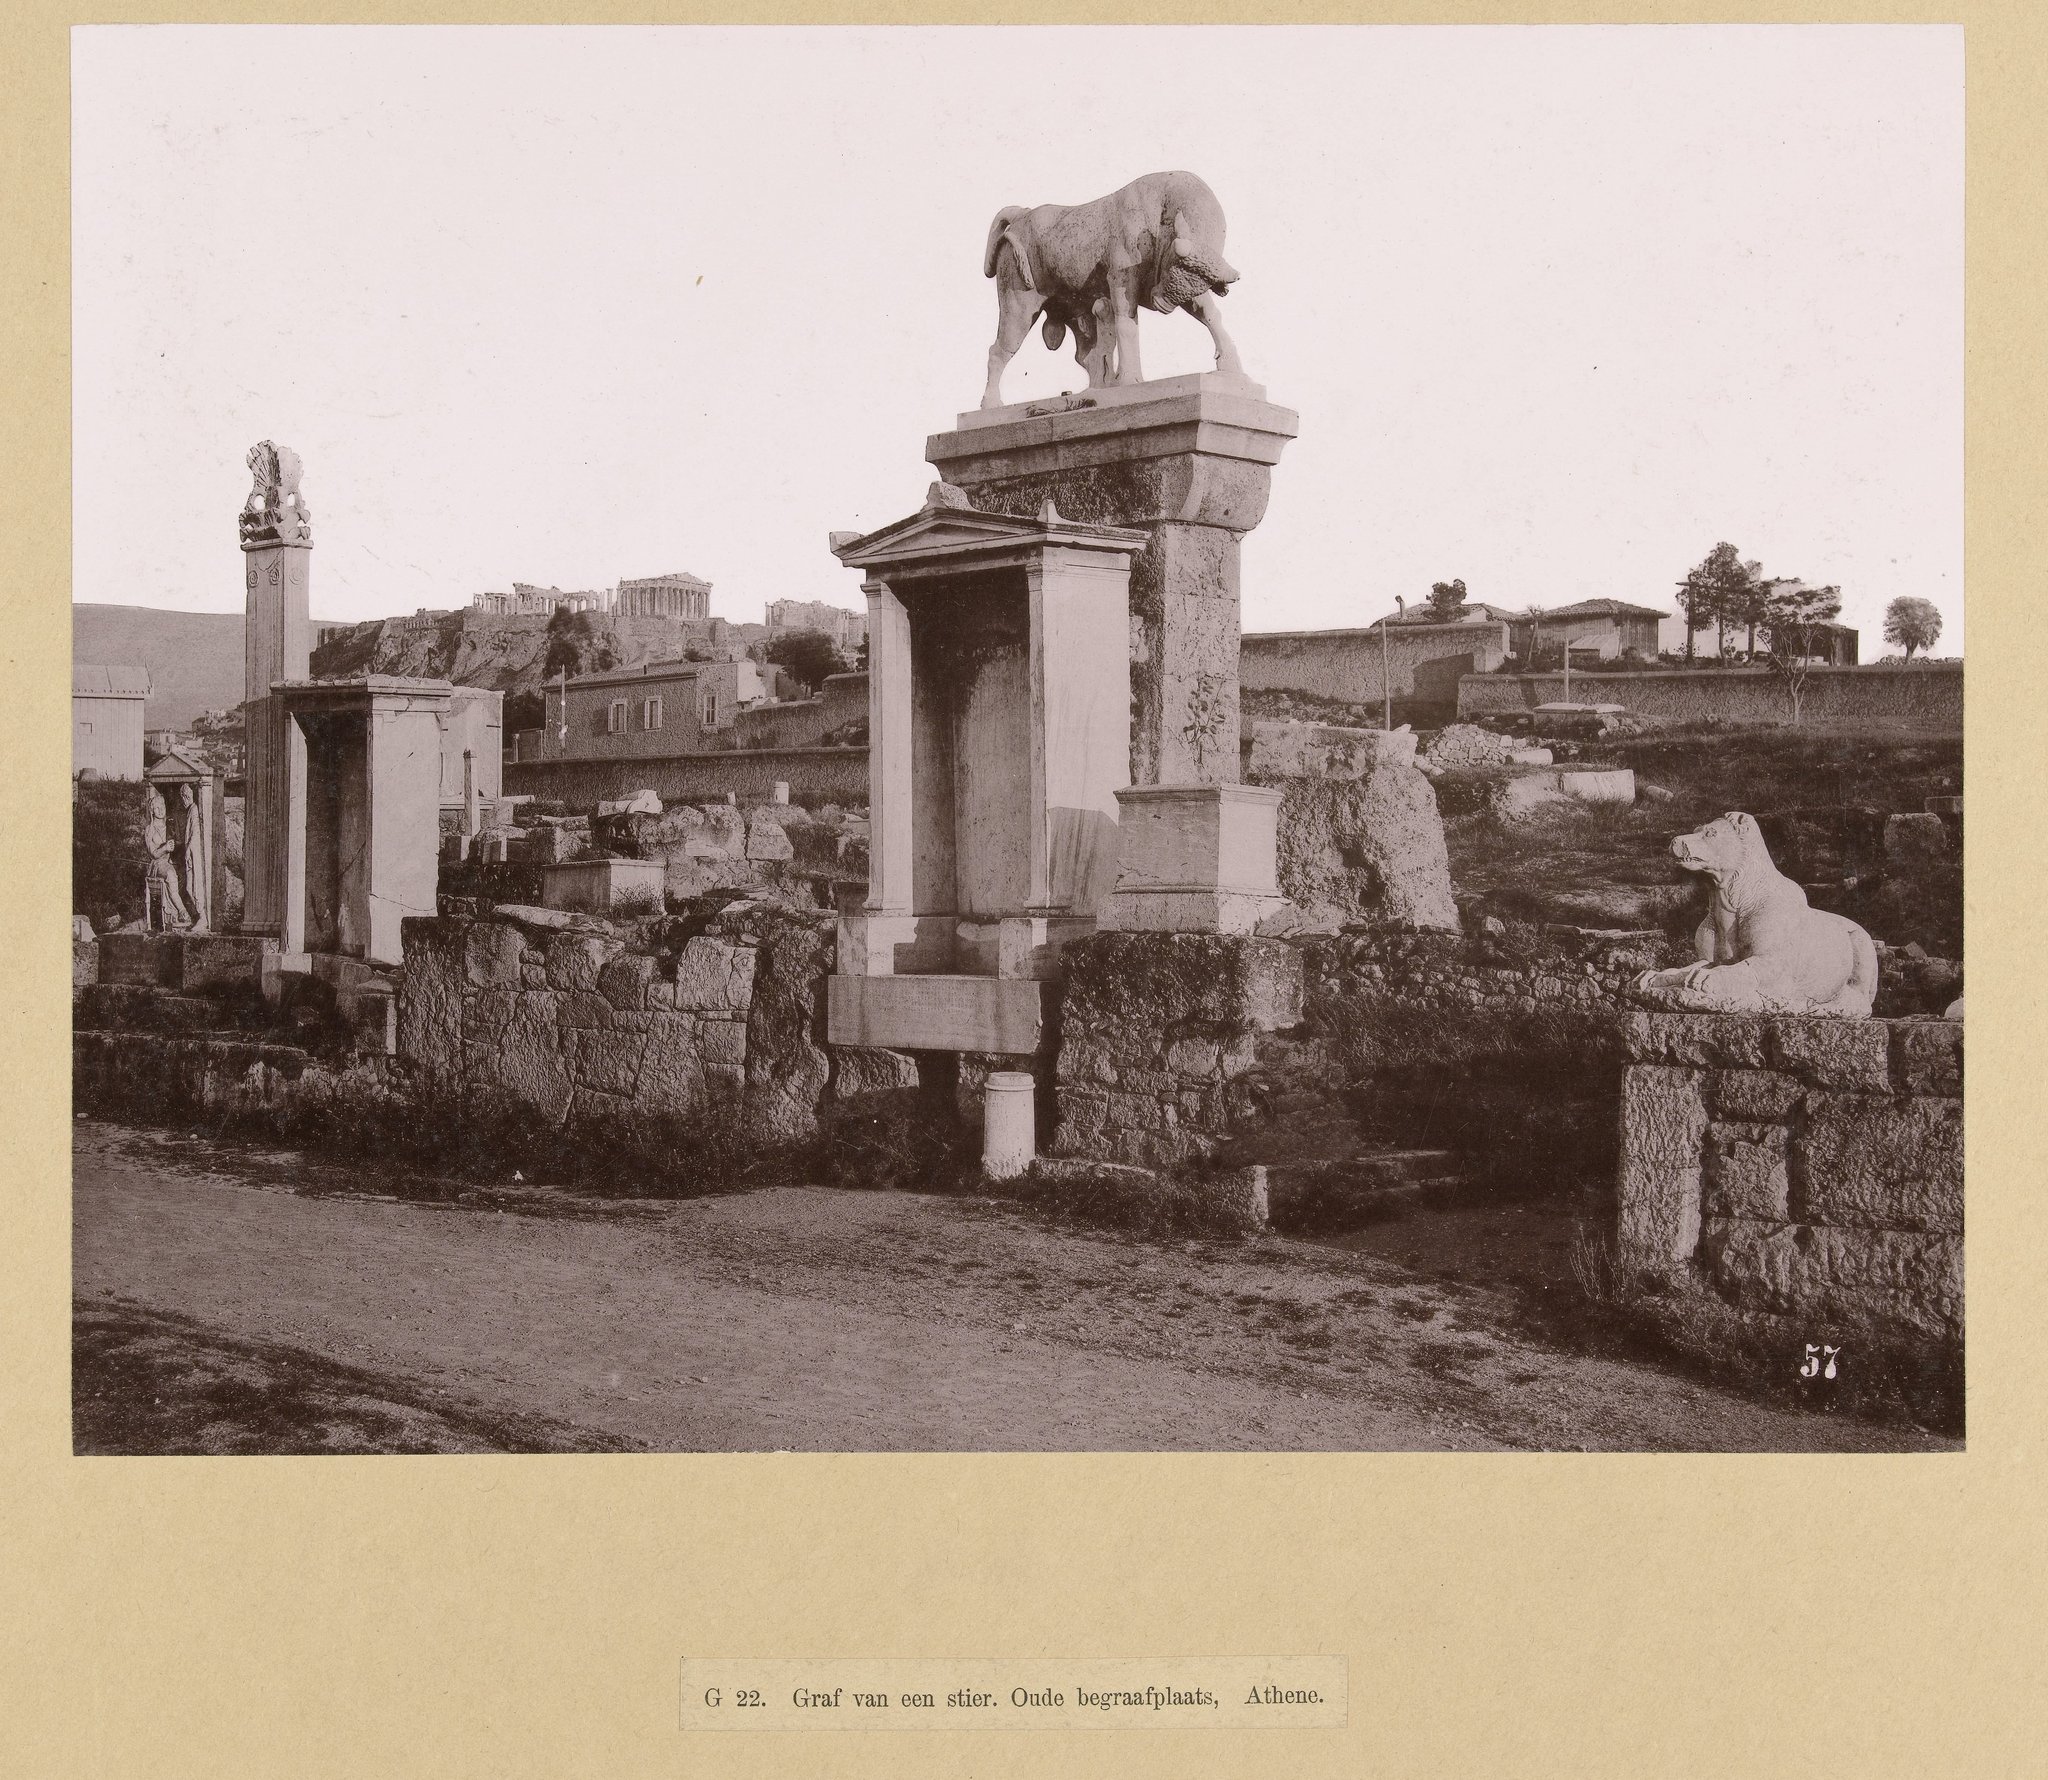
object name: photomechanical print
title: Graftombes op de begraafplaats van Athene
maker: Anonymous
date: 1890-1893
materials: cardboard, paper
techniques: photograph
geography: athens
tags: churchyard, cemetery, grave, tomb and other grave-forms and grave-markers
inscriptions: title: ‘G 22. Graf van een stier. Oude begraafplaats, Athene.’, stamp: ‘Gemeentelijke bibliotheek/ Rotterdam’, check stamp: ‘Bristol/ L.M.’, number: ‘57’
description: Onderdeel van een groep door fotograaf Richard Polak op reis verzamelde foto’s. Deze fotomechanische afdruk is samen met andere op zijn reizen verzamelde foto's tentoongesteld bij de Rotterdamsche Kunstkring (1895), Arti en Amicitiae te Amsterdam (1897-1898?) en Societeit 't Collegie te Kampen (datum vooralsnog onbekend).